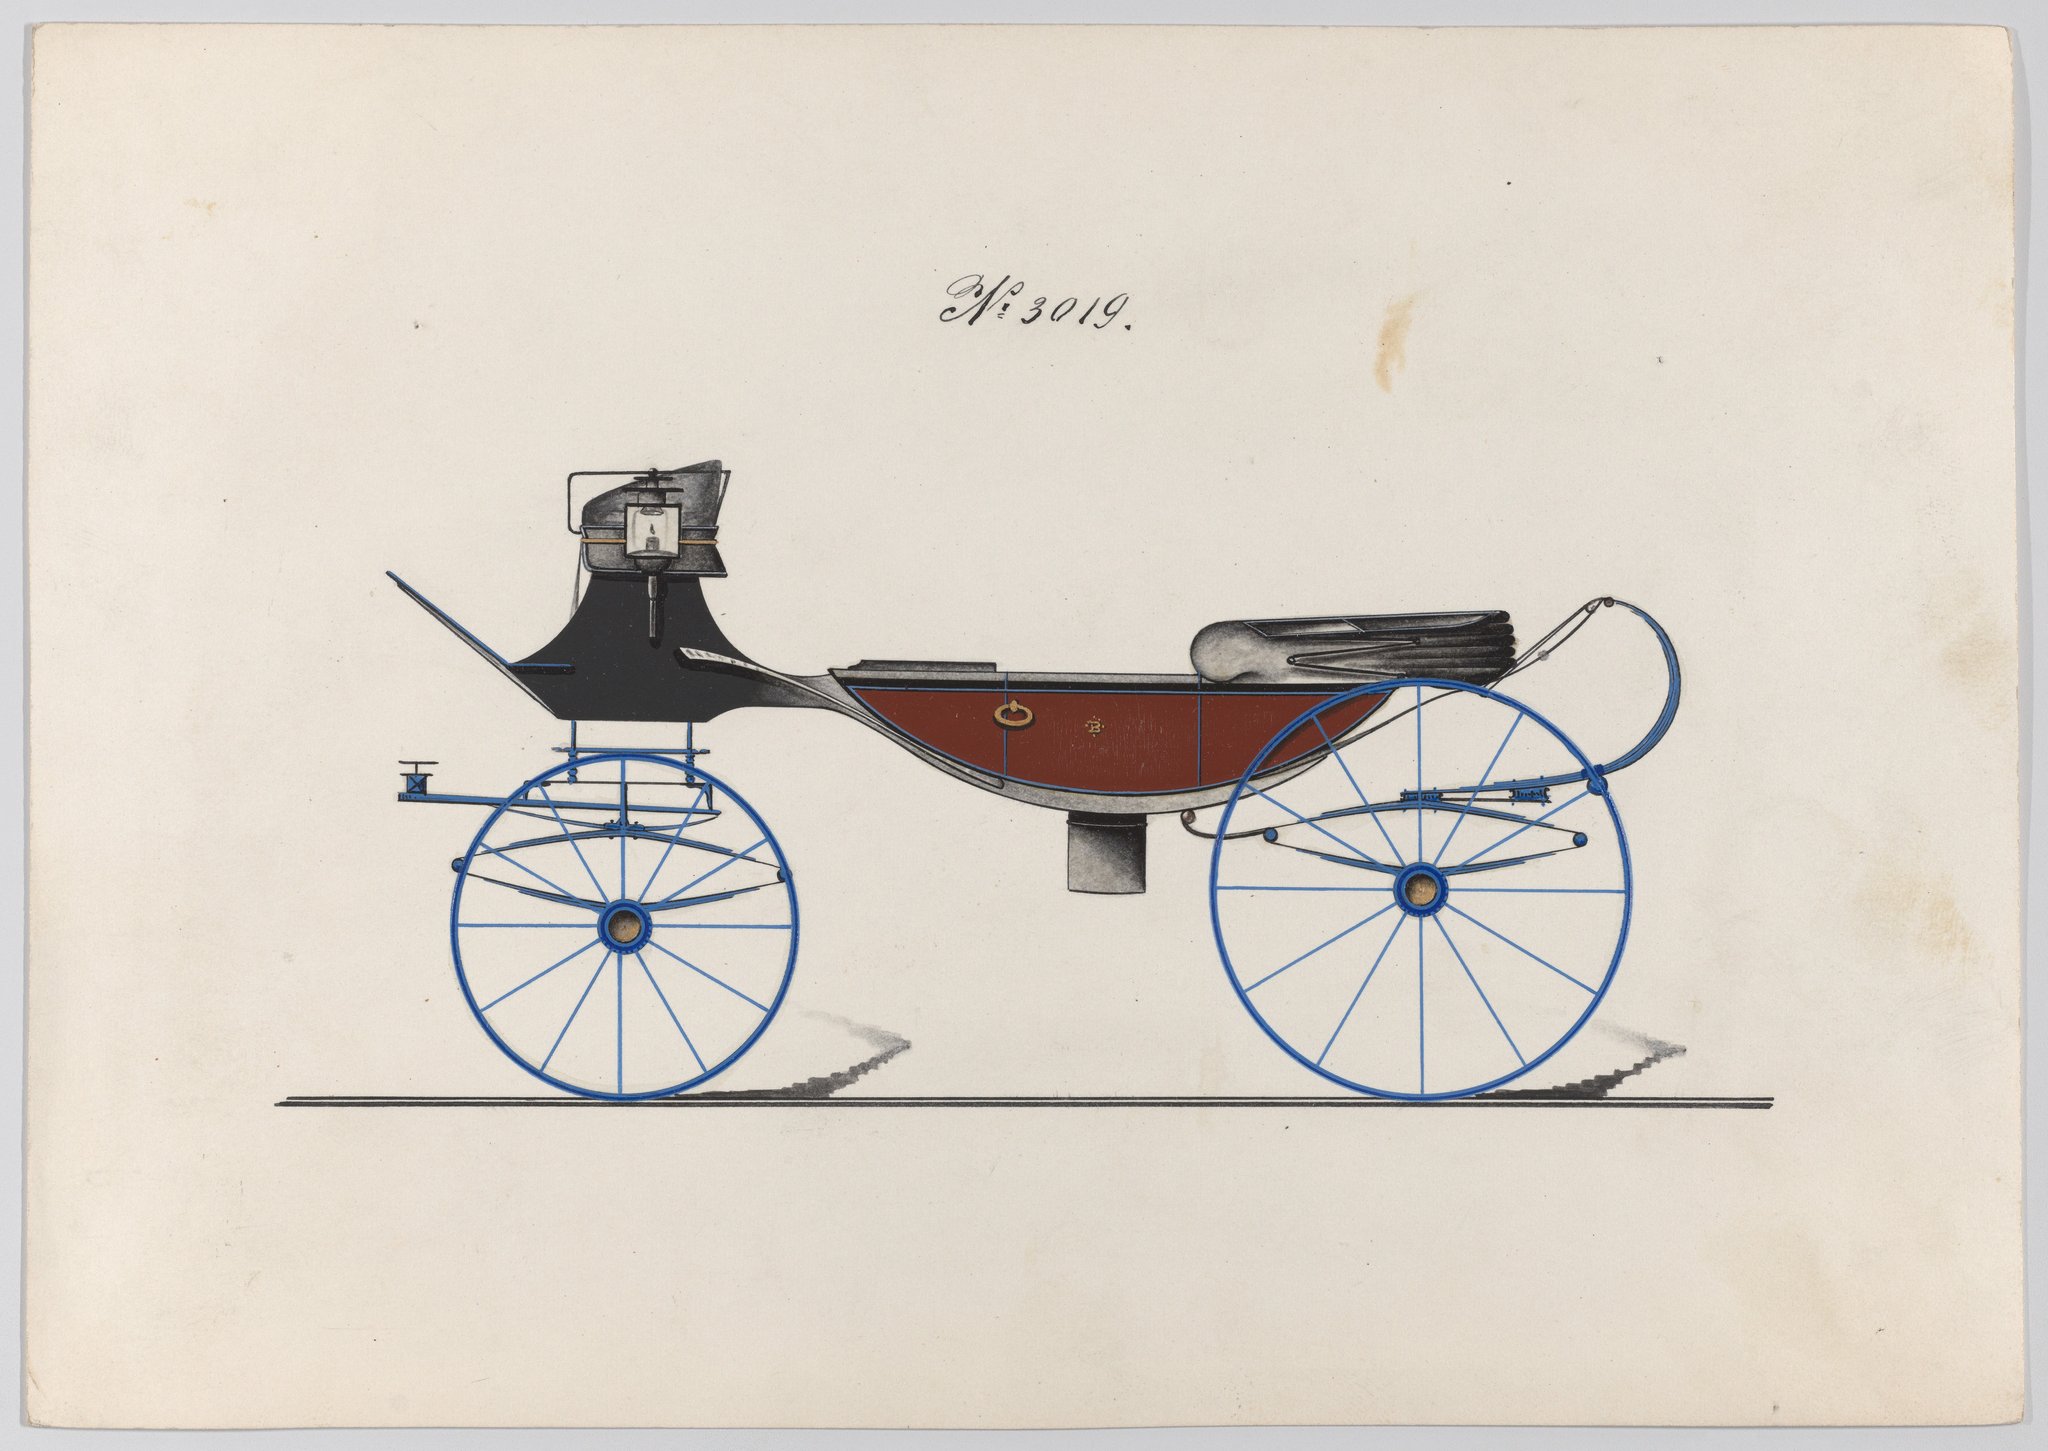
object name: drawing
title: Design for a Caleche or Vis-a-vis, no. 3019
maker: brewster & co.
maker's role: manufacturer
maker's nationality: american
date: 1874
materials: gouache, gum arabic, ink, watercolor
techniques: pen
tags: carriages